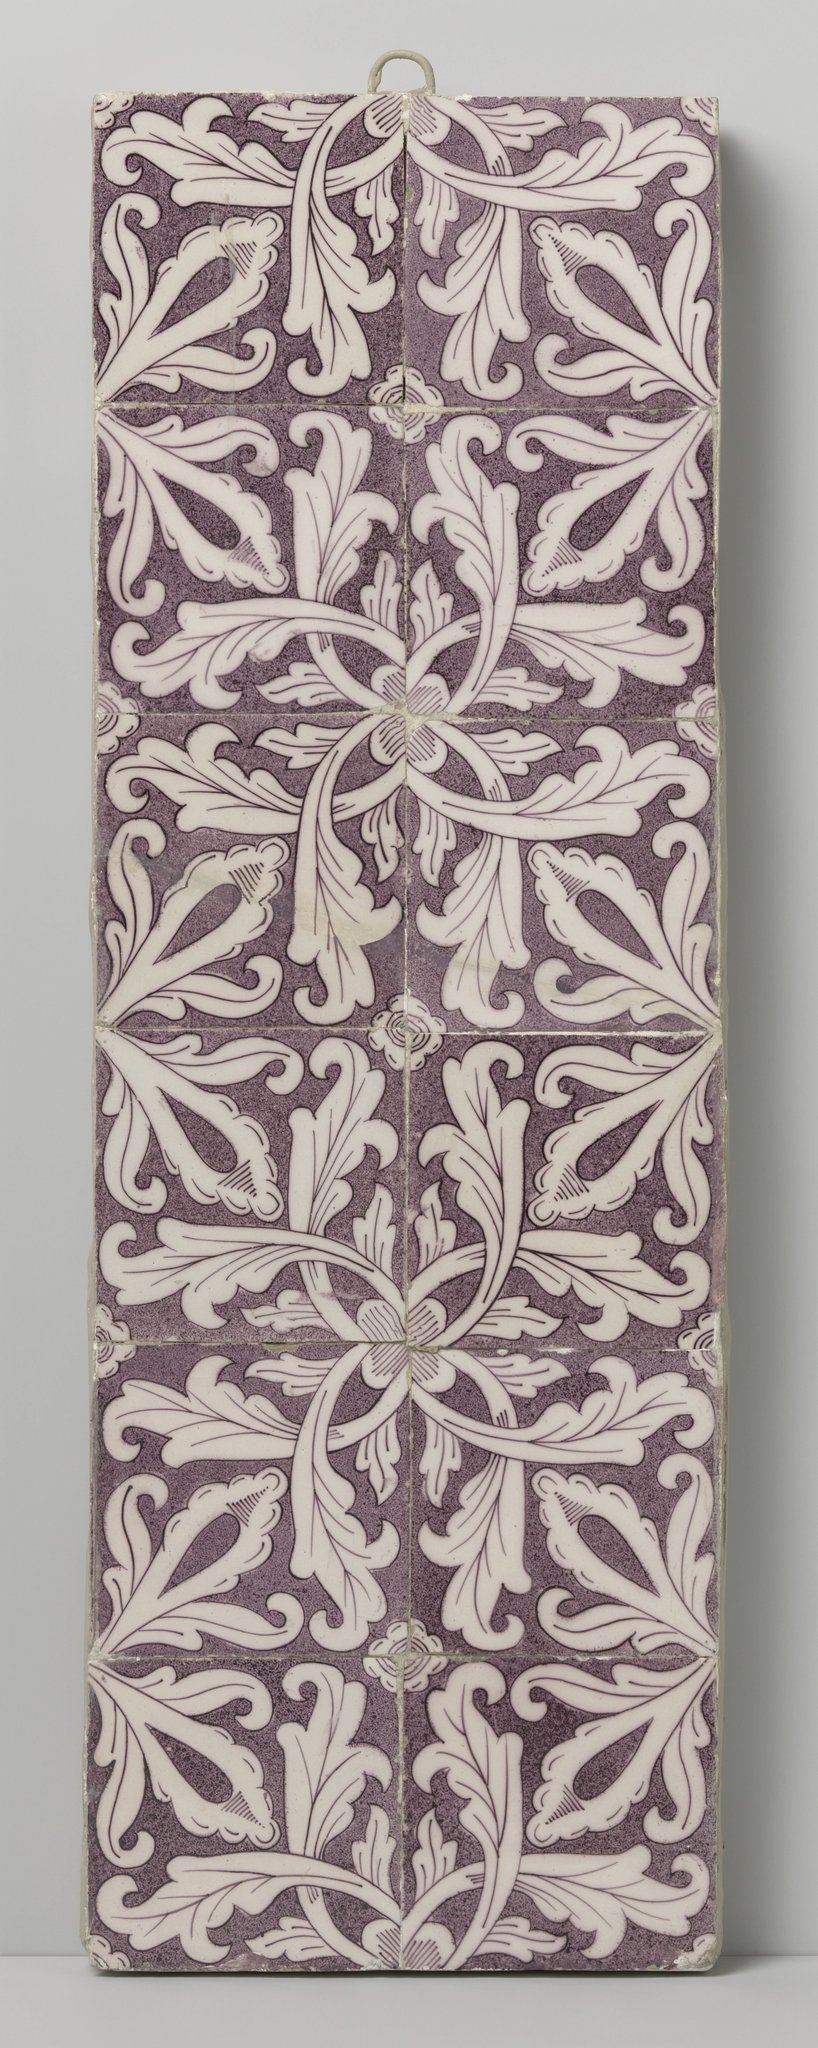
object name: tegelveld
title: Tegelveld van twaalf tegels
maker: Anonymous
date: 1725-1825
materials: earthenware, glaze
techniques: maiolica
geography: netherlands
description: Tegelveld van 12 tegels (6 x 2) met een uitgespaard patroon van acanthusbladeren tegen een paars fond.